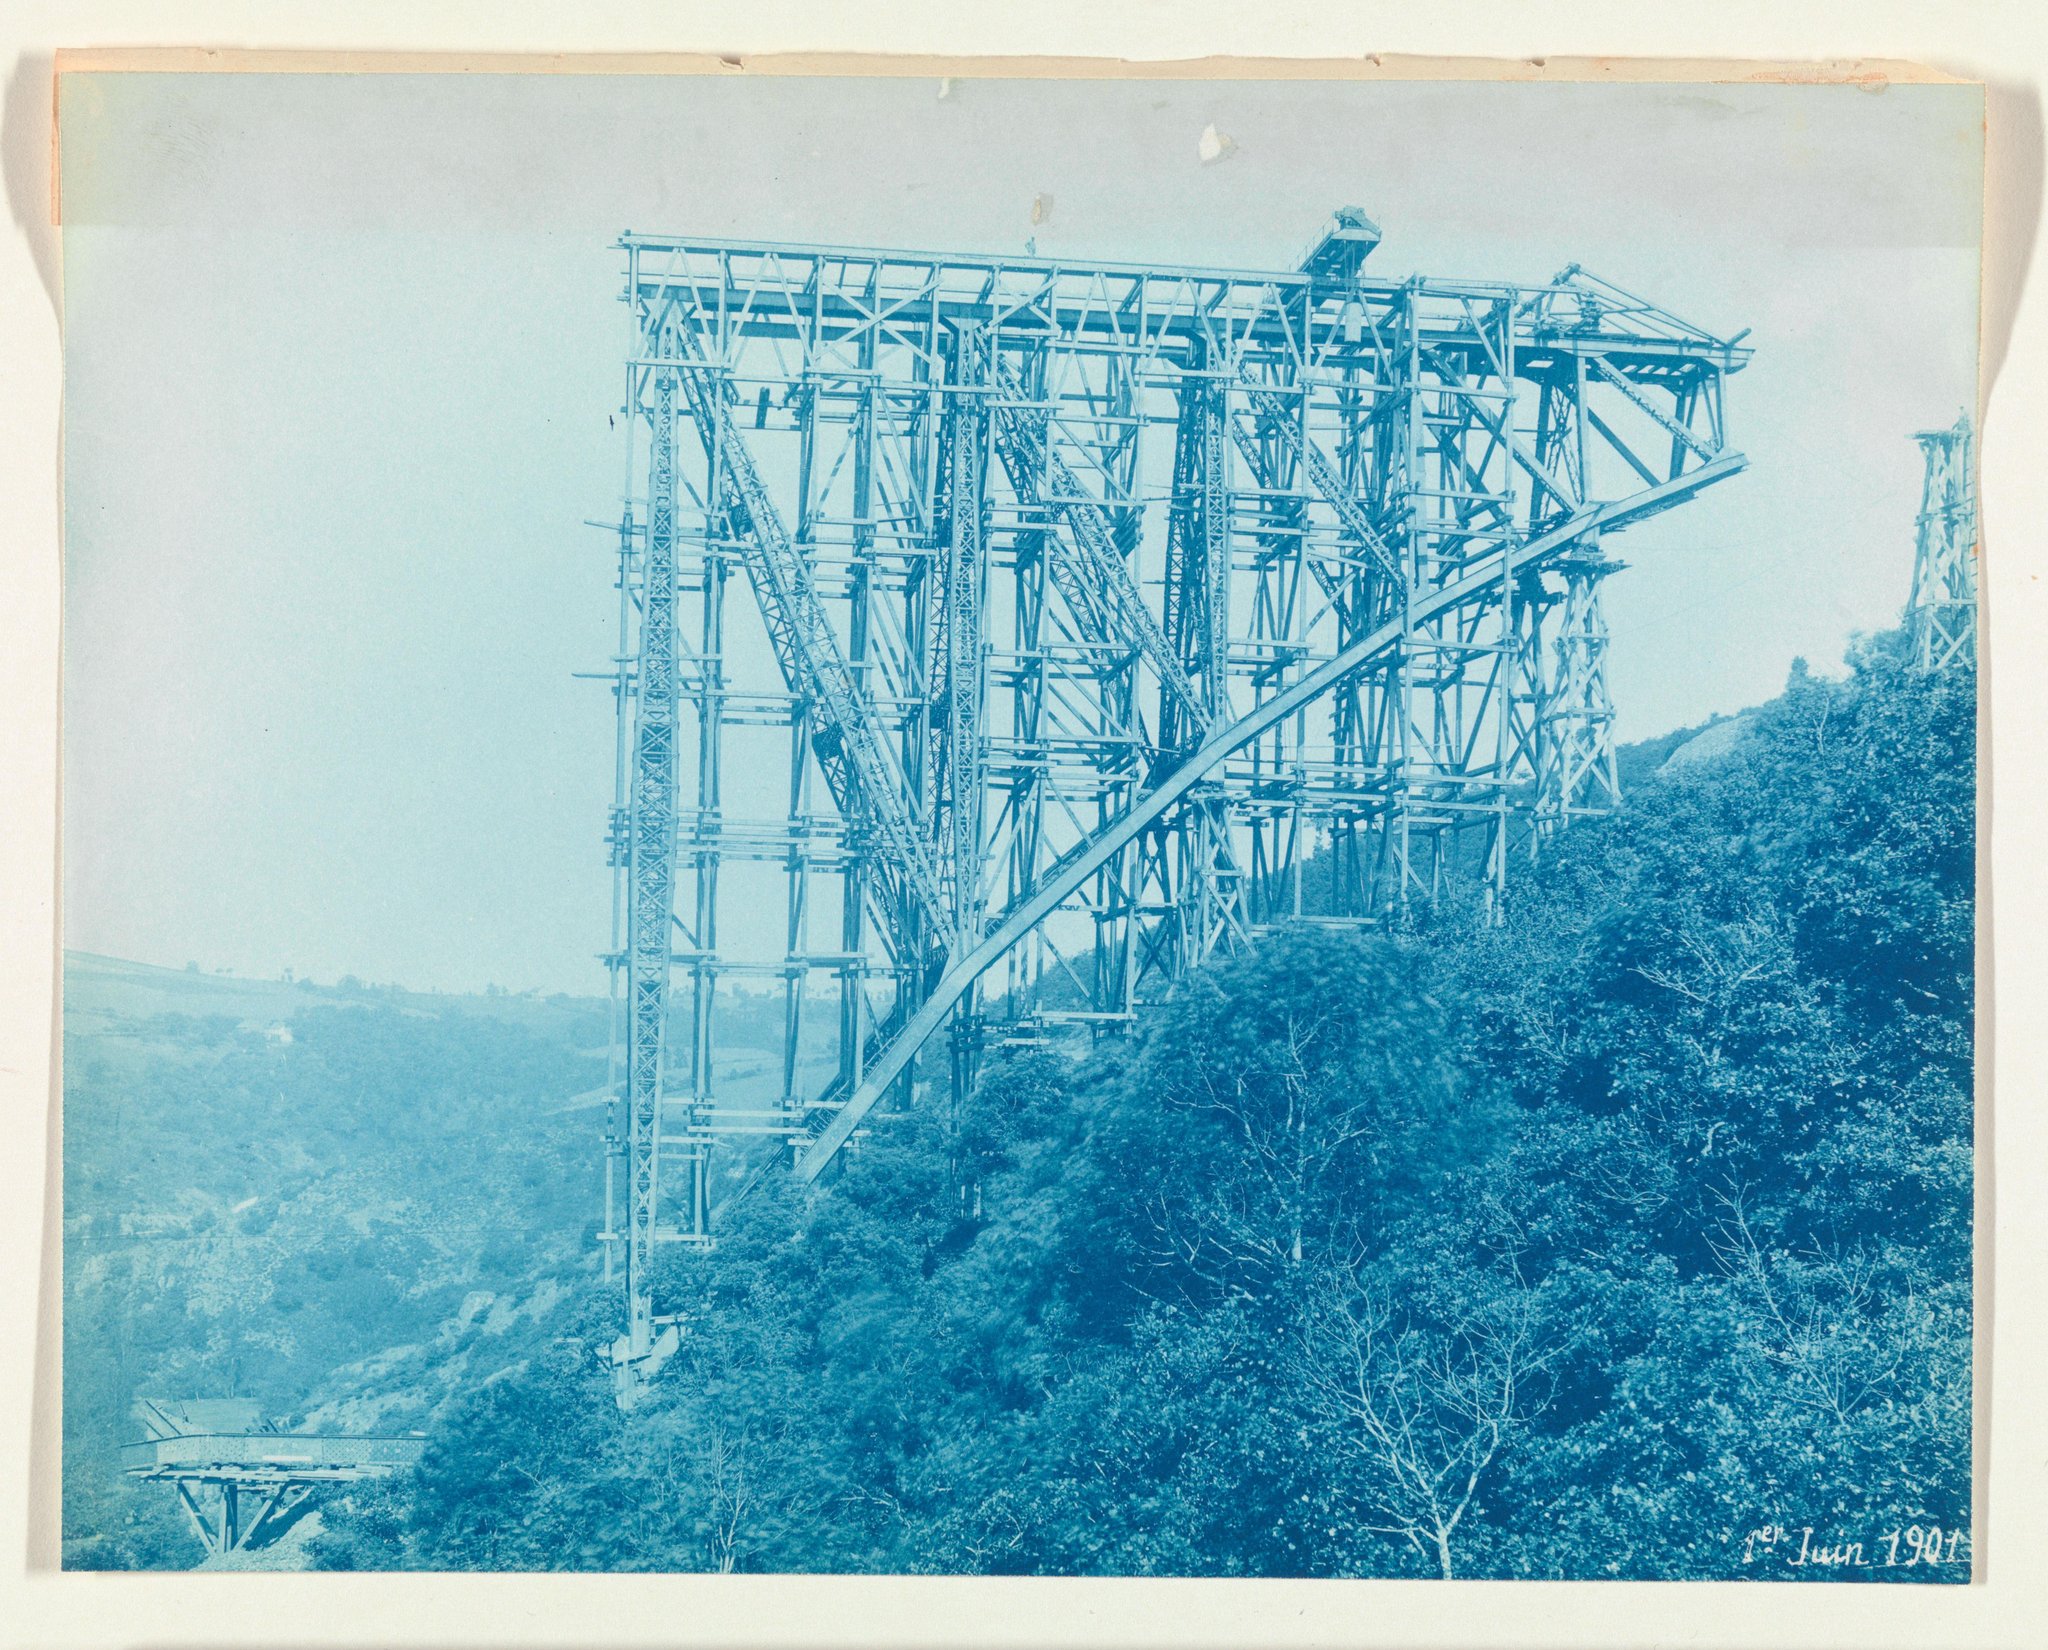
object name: photograph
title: Aanleg van het Viaur Viaduct in Frankrijk door de Societé de Construction des Battignolles, 1 juni 1901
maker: Anonymous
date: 1901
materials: photographic support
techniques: cyanotype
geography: france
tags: viaduct, making the overground structures (~ building activities)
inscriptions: date